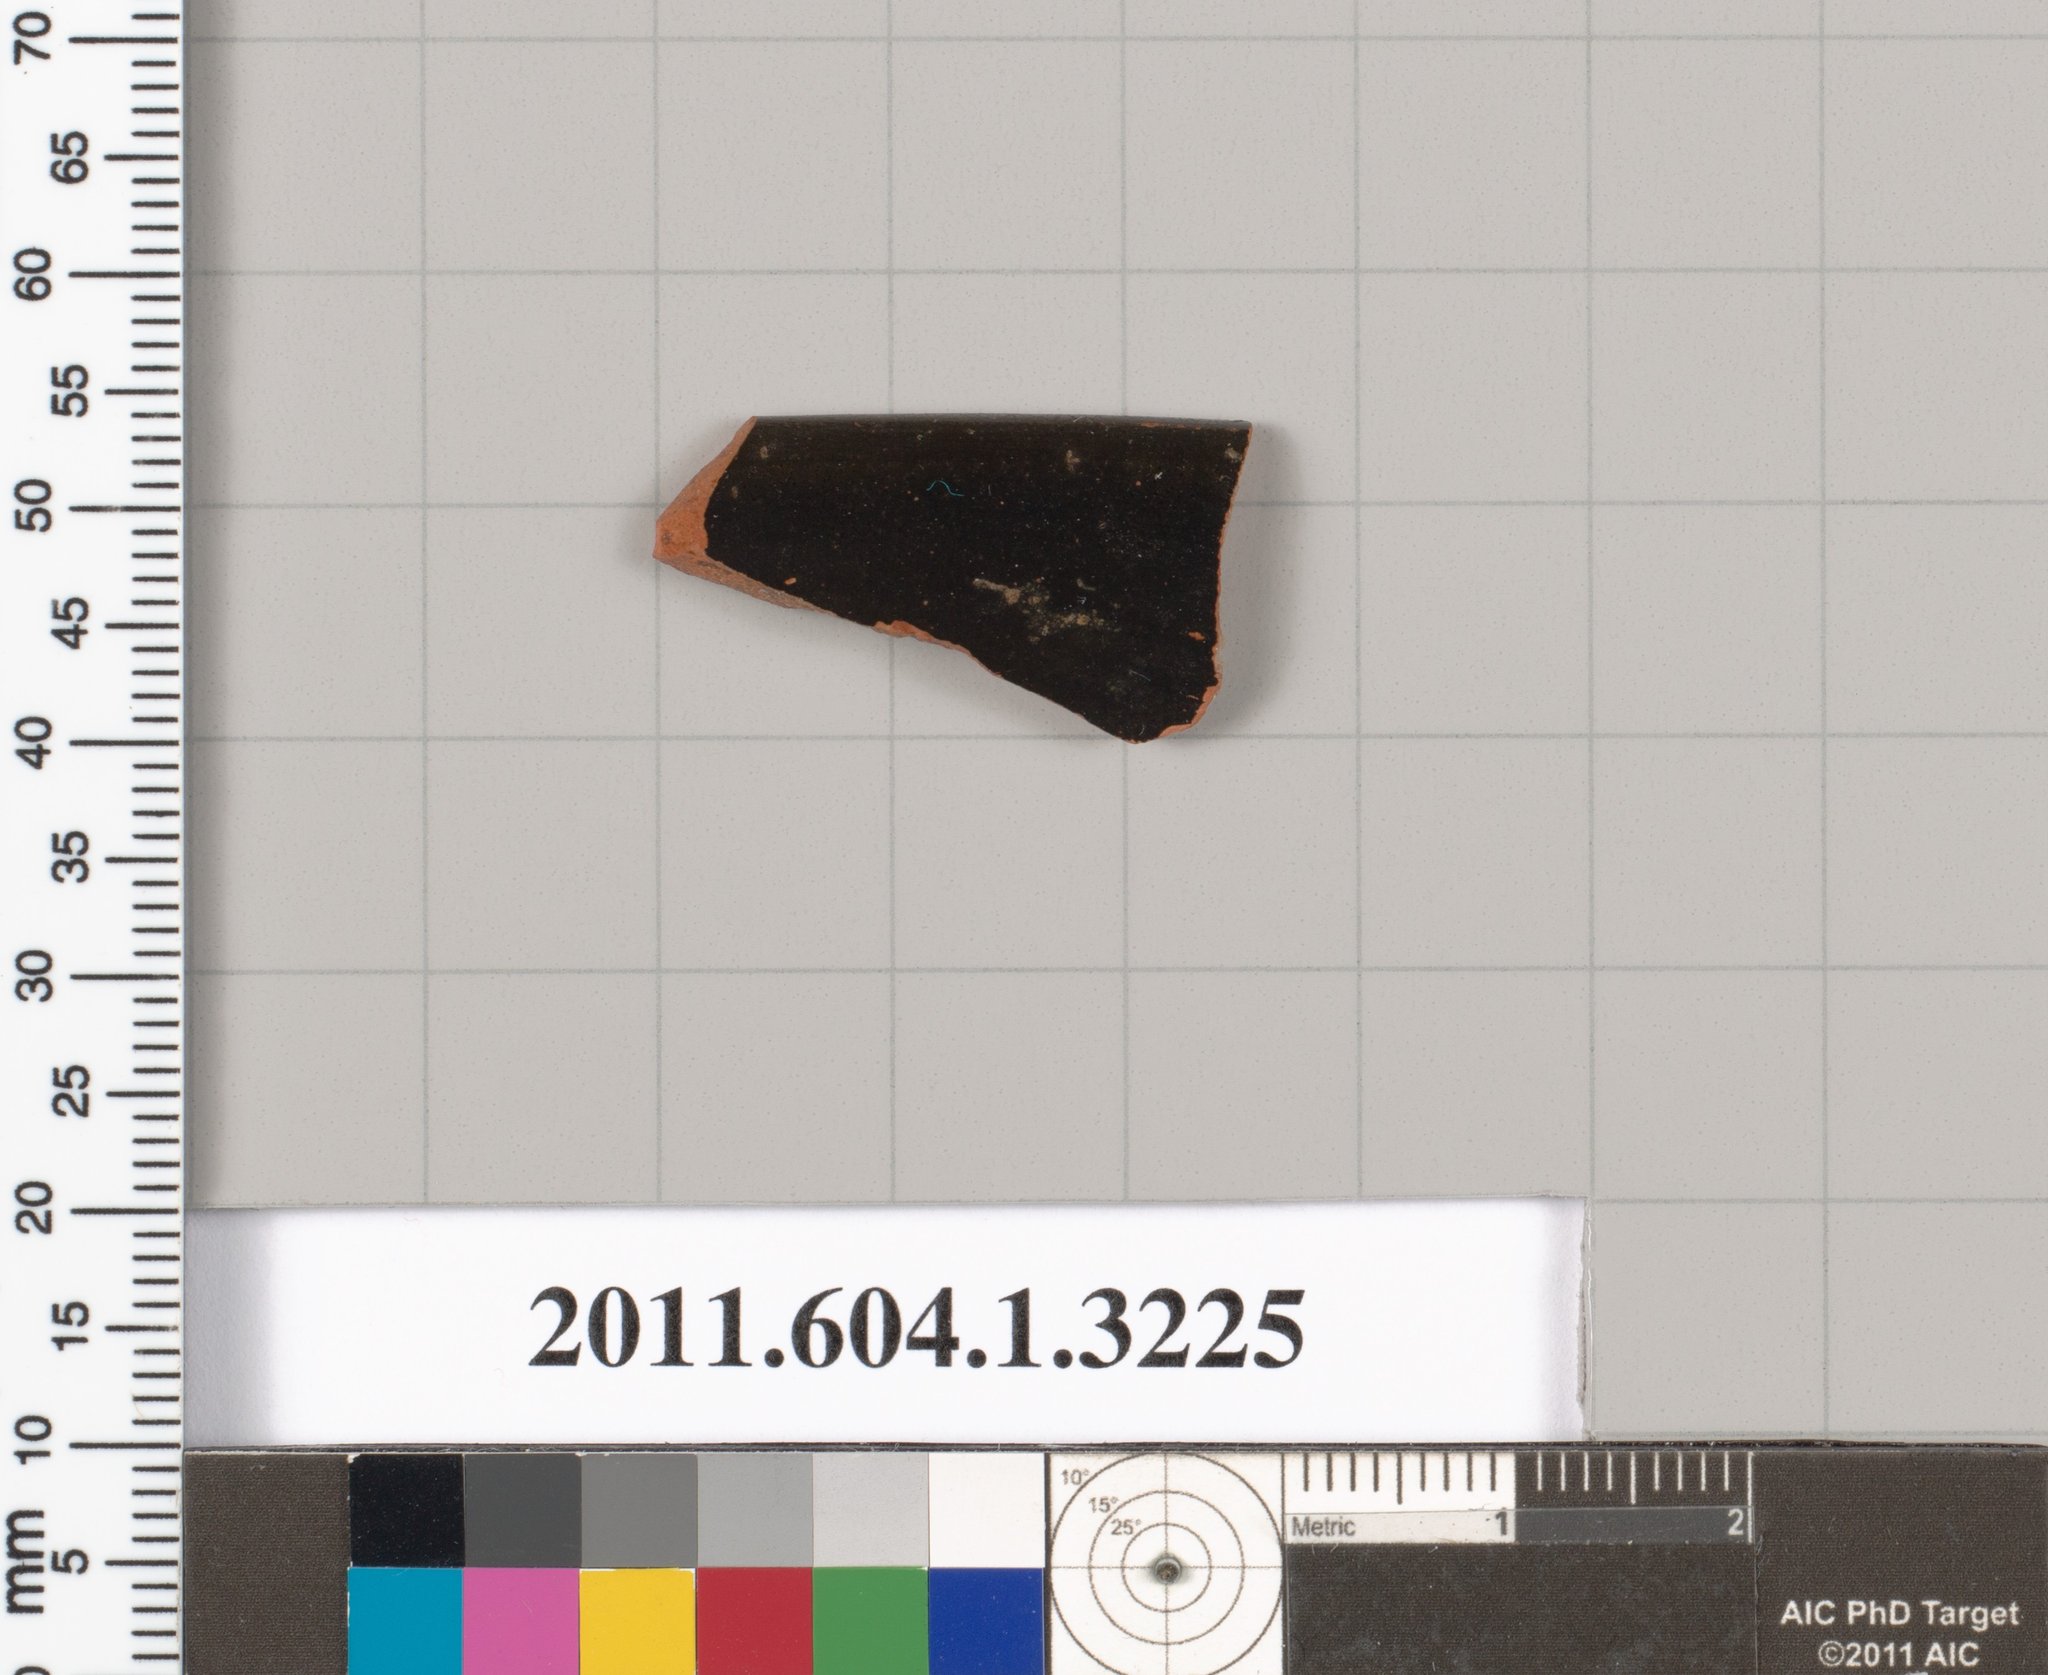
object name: kylix fragment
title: Terracotta rim fragment of a kylix (drinking cup)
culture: greek, attic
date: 600-401 BCE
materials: terracotta